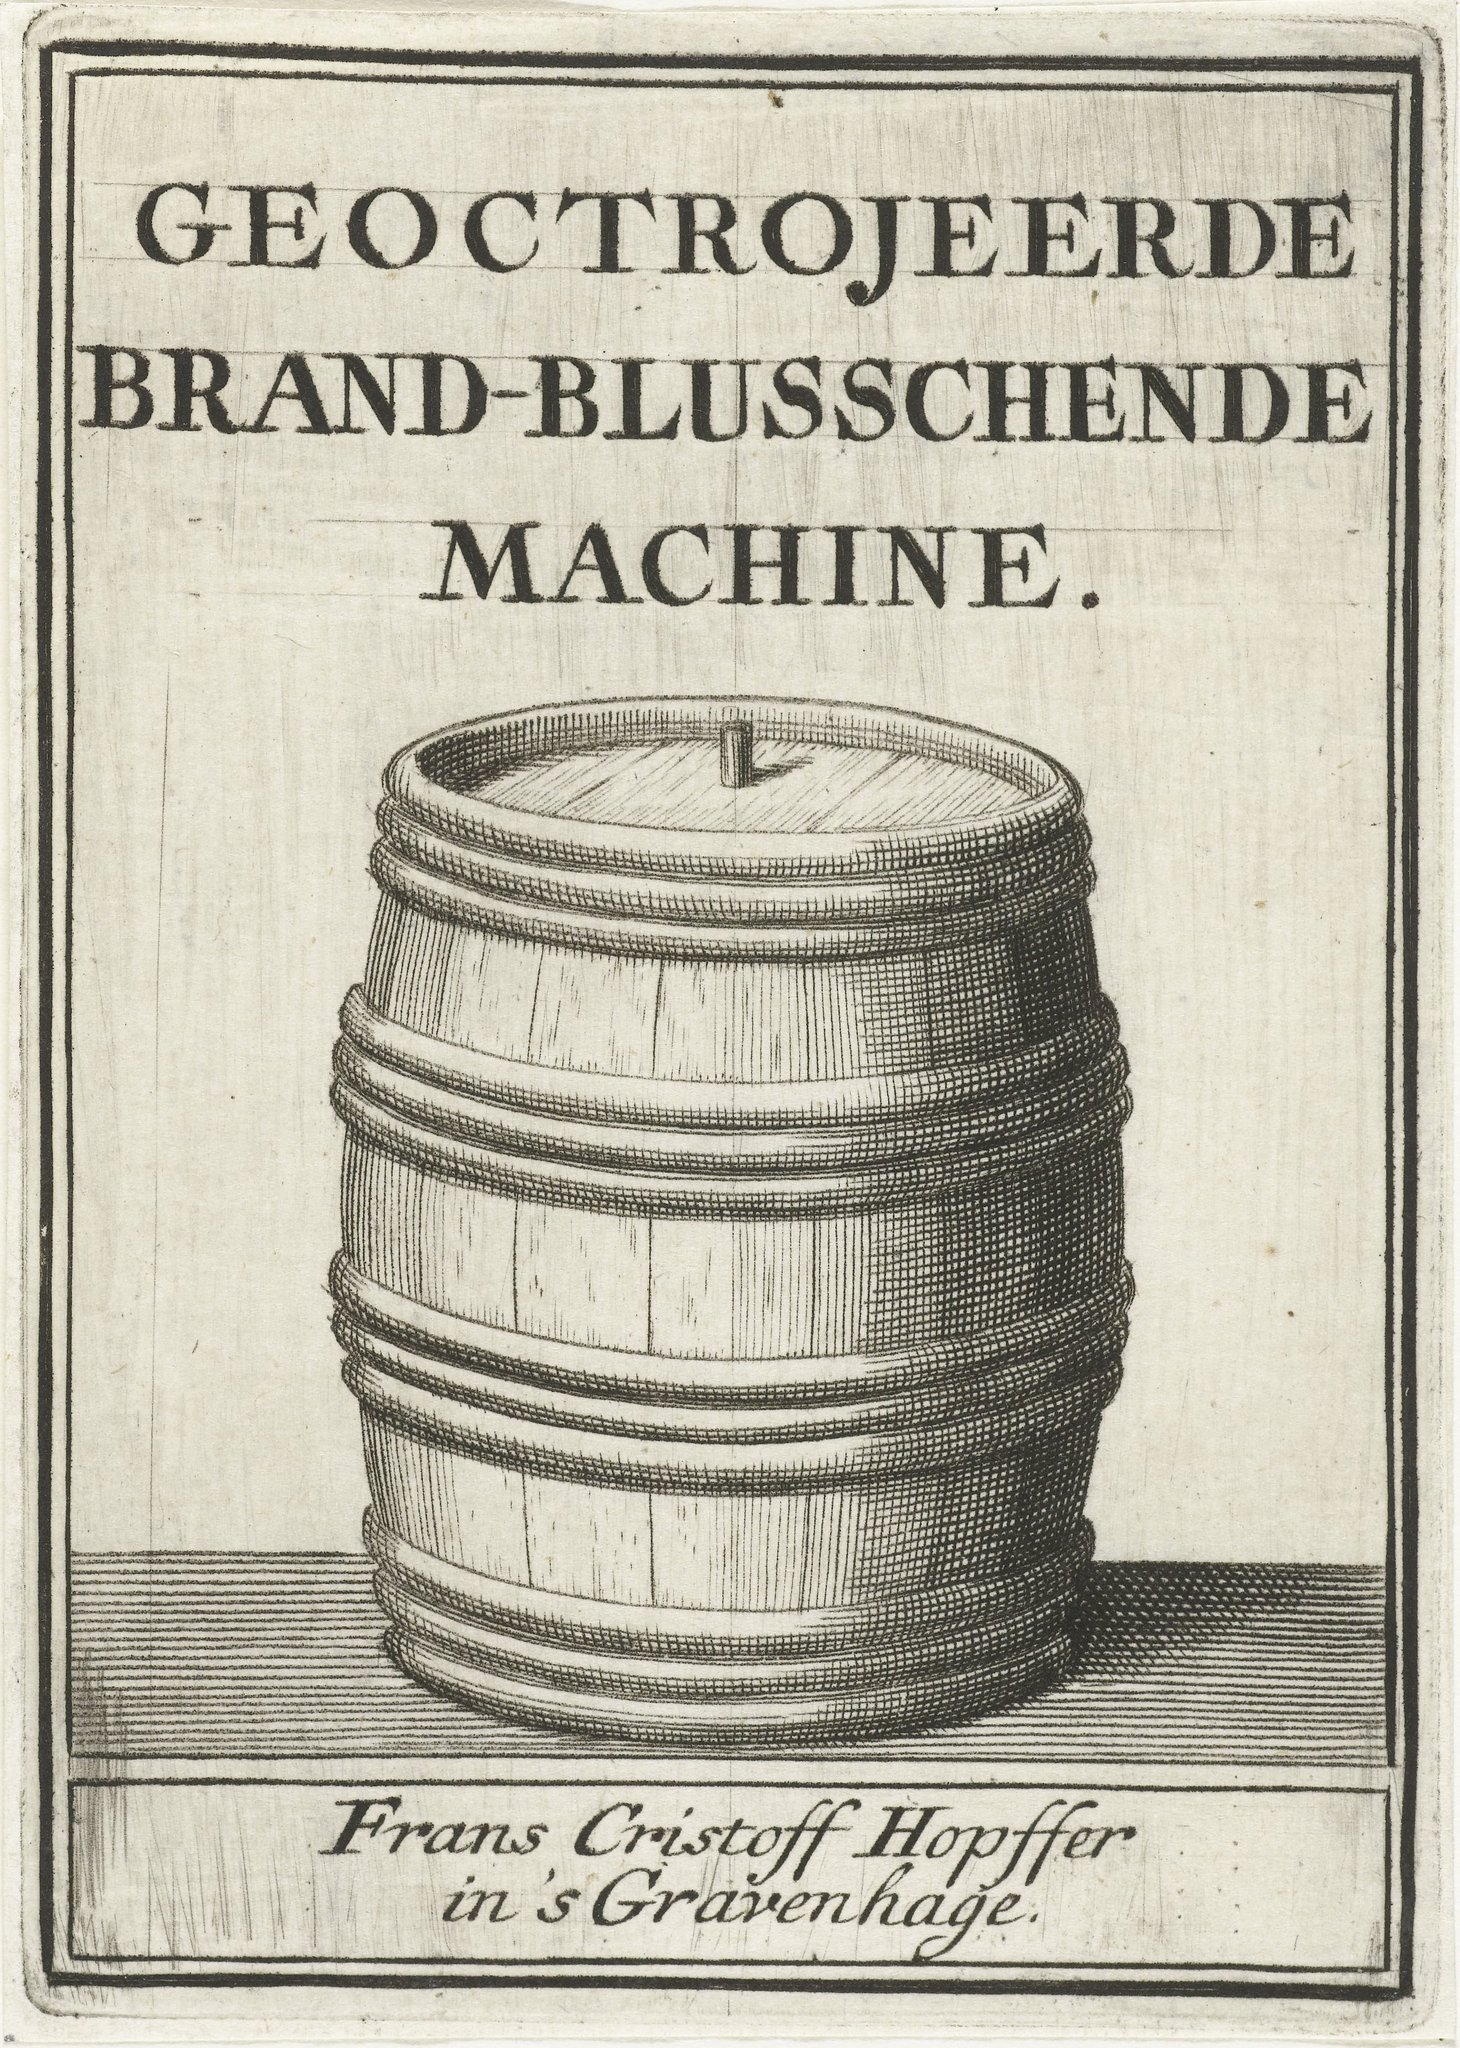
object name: print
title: Brandblusmachine, ca. 1750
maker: Anonymous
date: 1740-1760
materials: paper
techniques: engraving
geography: northern netherlands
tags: wooden container: barrel, cask, bucket, fire-extinguishing equipment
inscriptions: collector's mark: Lugt 2228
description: Een geoctrooieerde machine in de vorm van een houten vat voor het blussen van brand, uitgevonden door Frans Cristoff Hopffer te Den Haag, ca. 1750.